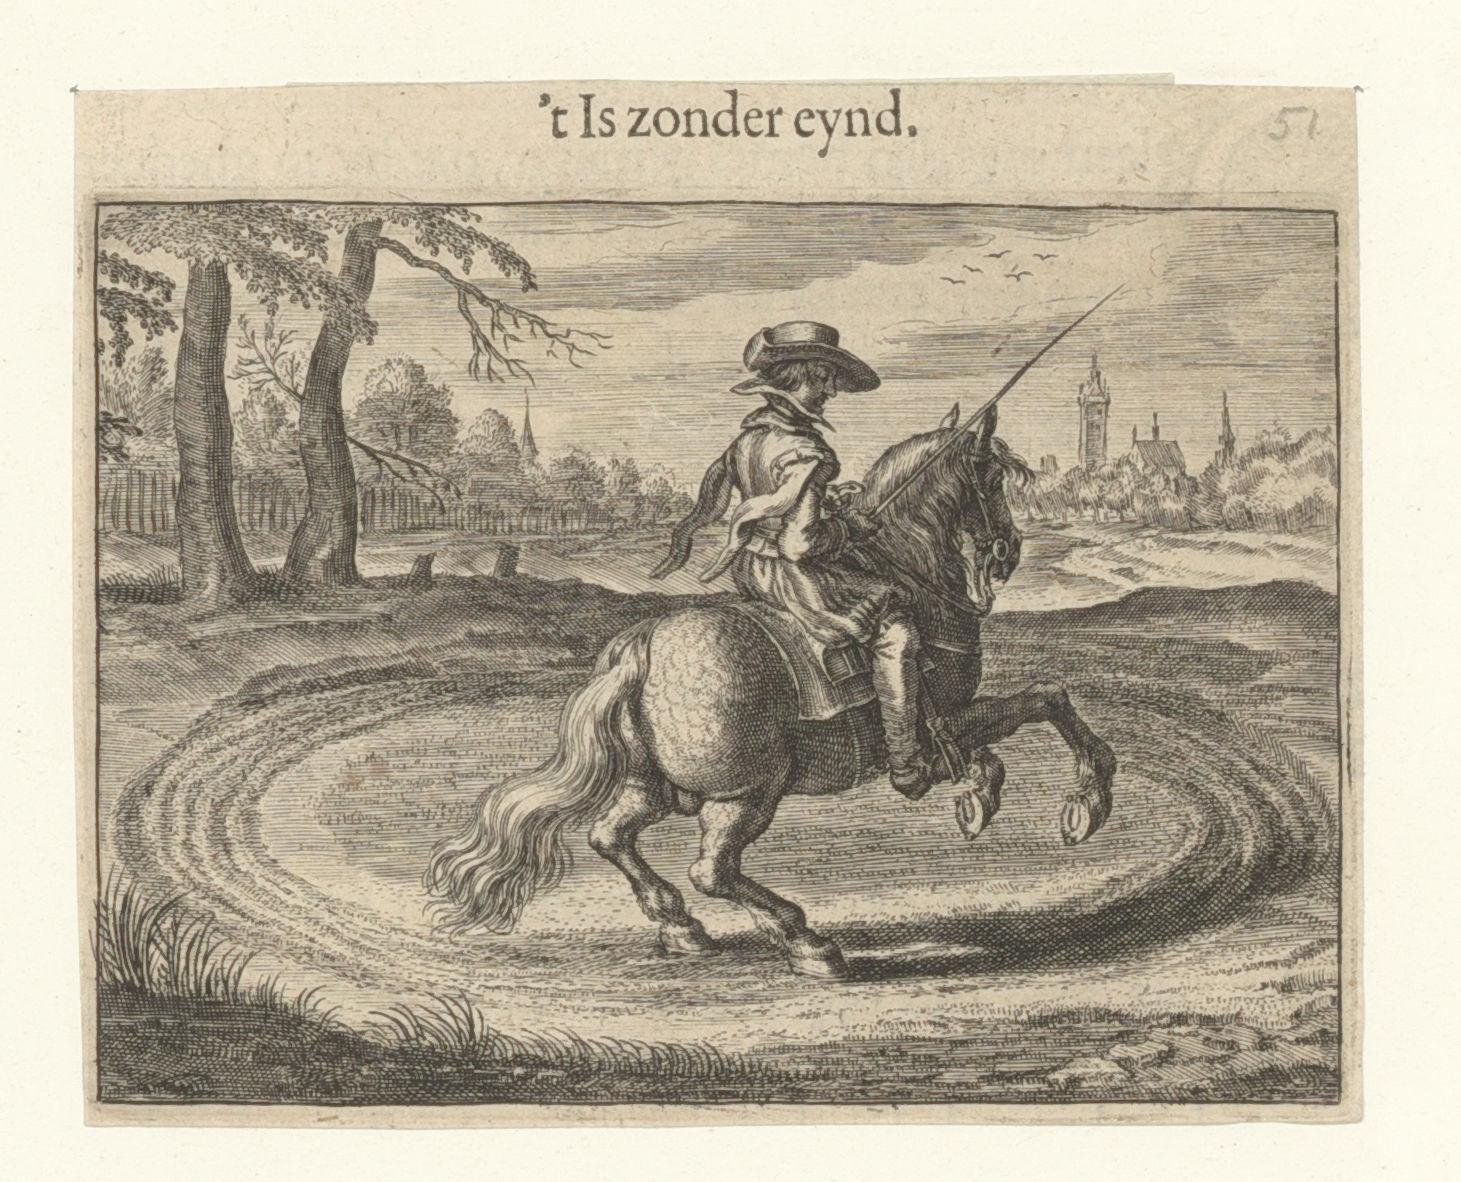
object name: print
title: 't Is zonder eynd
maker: Anonymous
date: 1624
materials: paper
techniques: engraving, letterpress printing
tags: riding a horse, ass, or mule; rider, horseman, adult man, eternity, 'aeternitas'; 'eternità','eternità o perpetuità' (ripa), proverbs, sayings, etc., training of horses, circle (~ planimetry, geometry)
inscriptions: collector's mark: Lugt 1641, stamp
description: Prent uit: Brune, Johan de. Zinne-werck, Voor-ghesyelt in Beelden, Ghedichten, ende breeder uyt-legginghen (...). Amsterdam: Evertsen Kloppenburch, 1624. Prent ook gebruikt in latere edities (1636 en 1661).